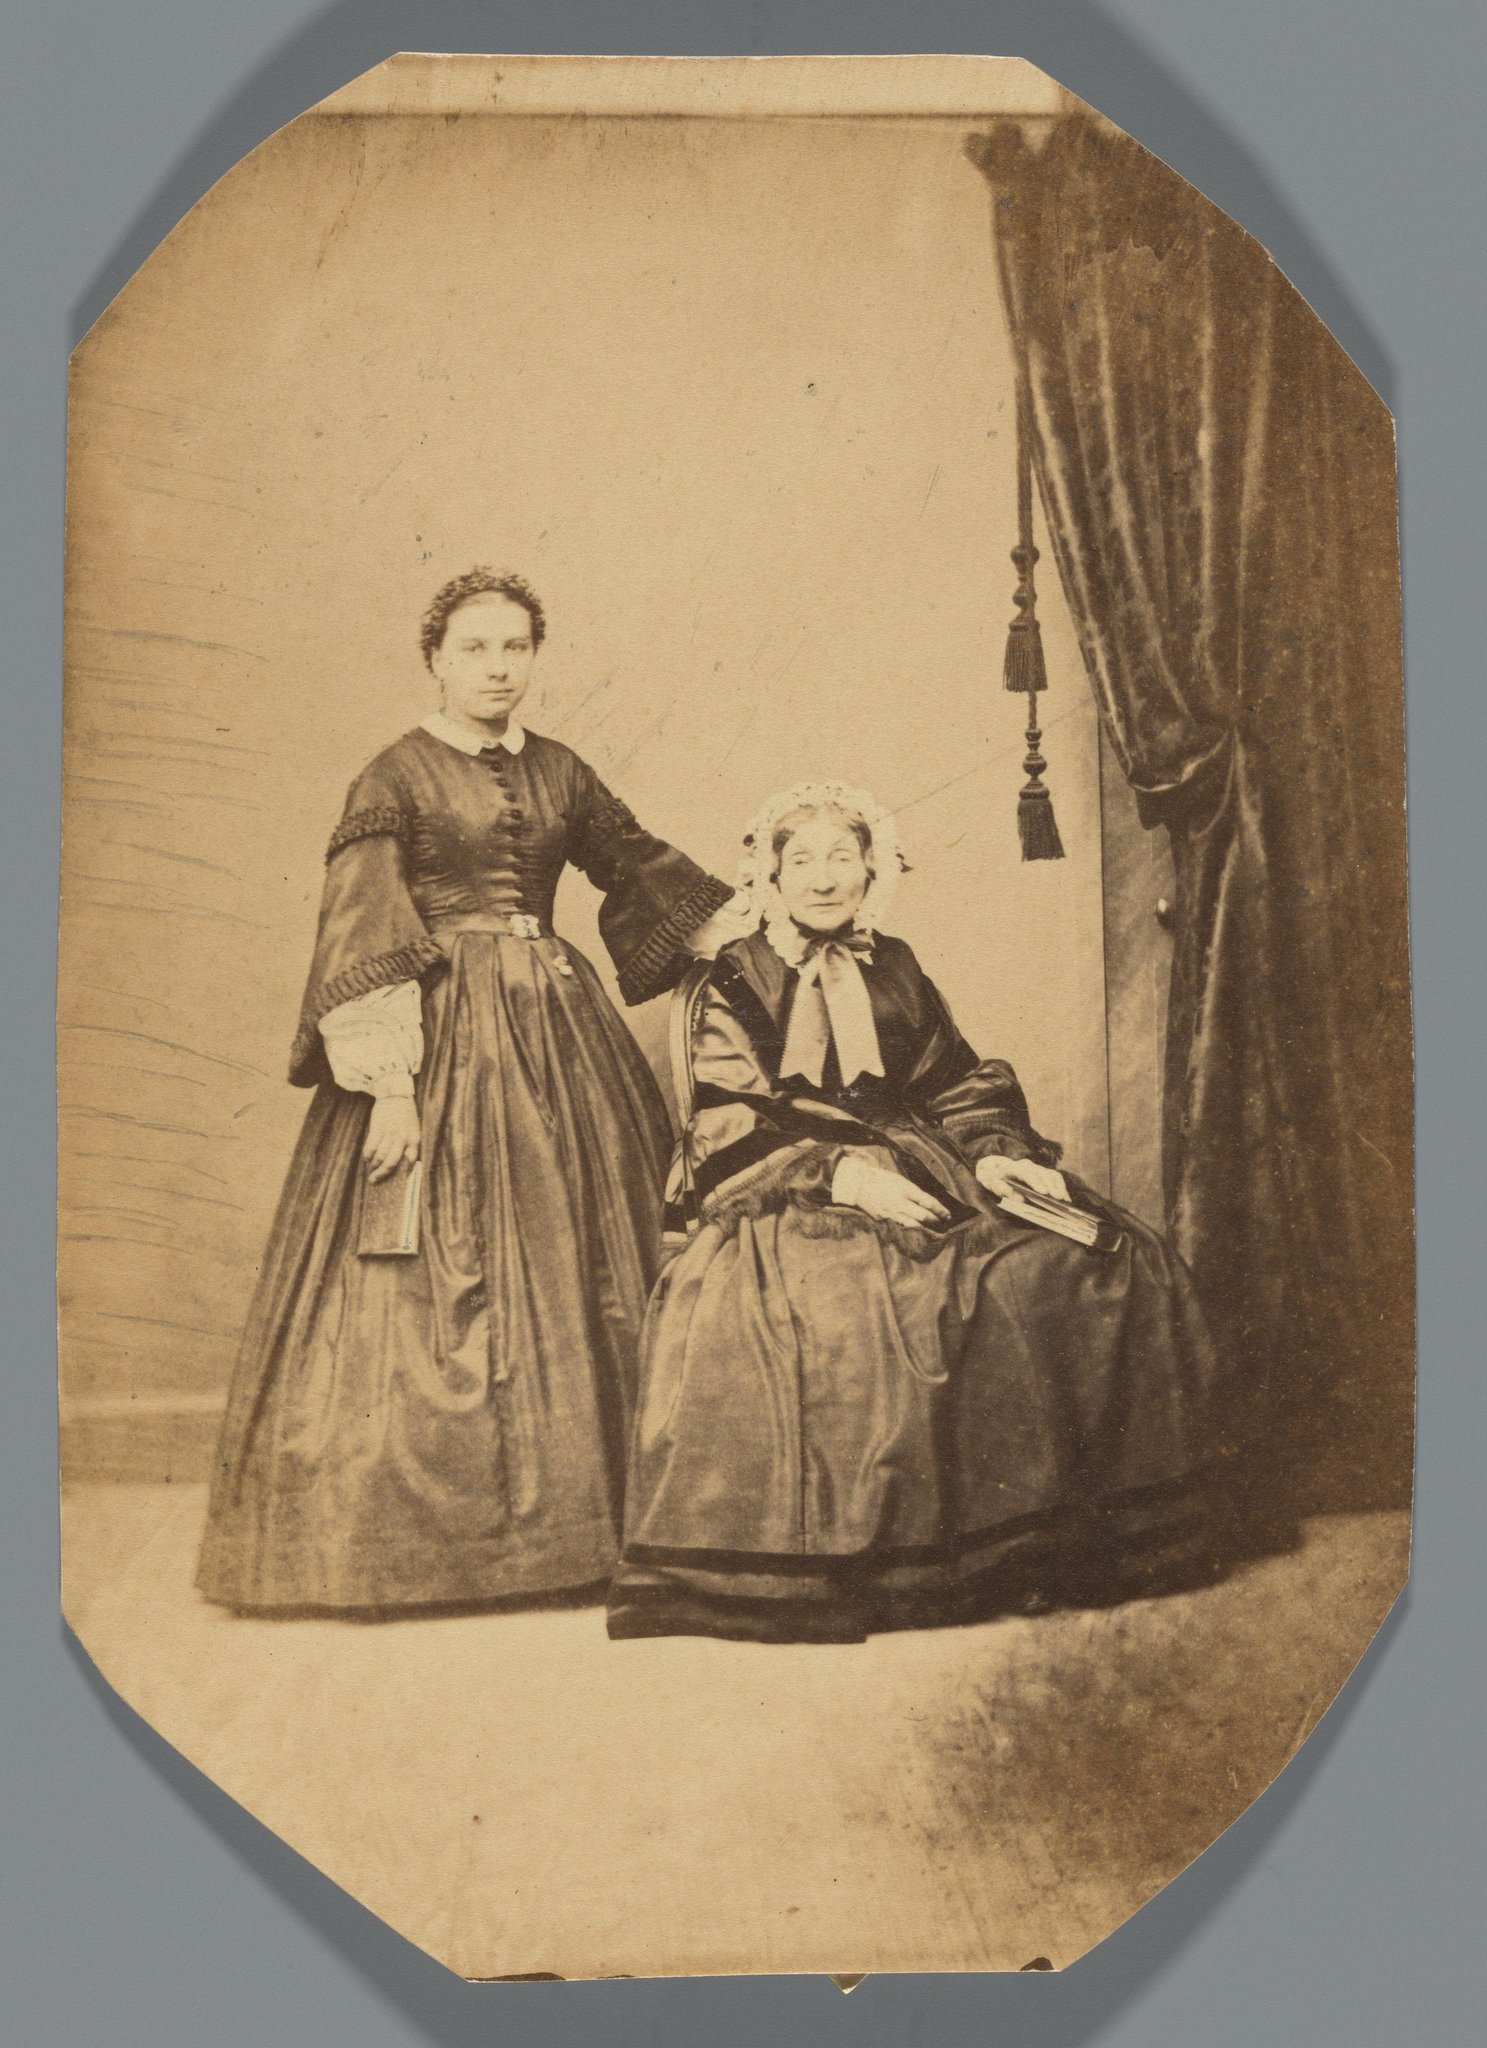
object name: photograph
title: Portret van twee onbekende vrouwen met een boek in de hand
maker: Anonymous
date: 1851-1865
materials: paper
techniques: albumen print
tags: anonymous historical persons portrayed in a double portrait - bb - woman, book